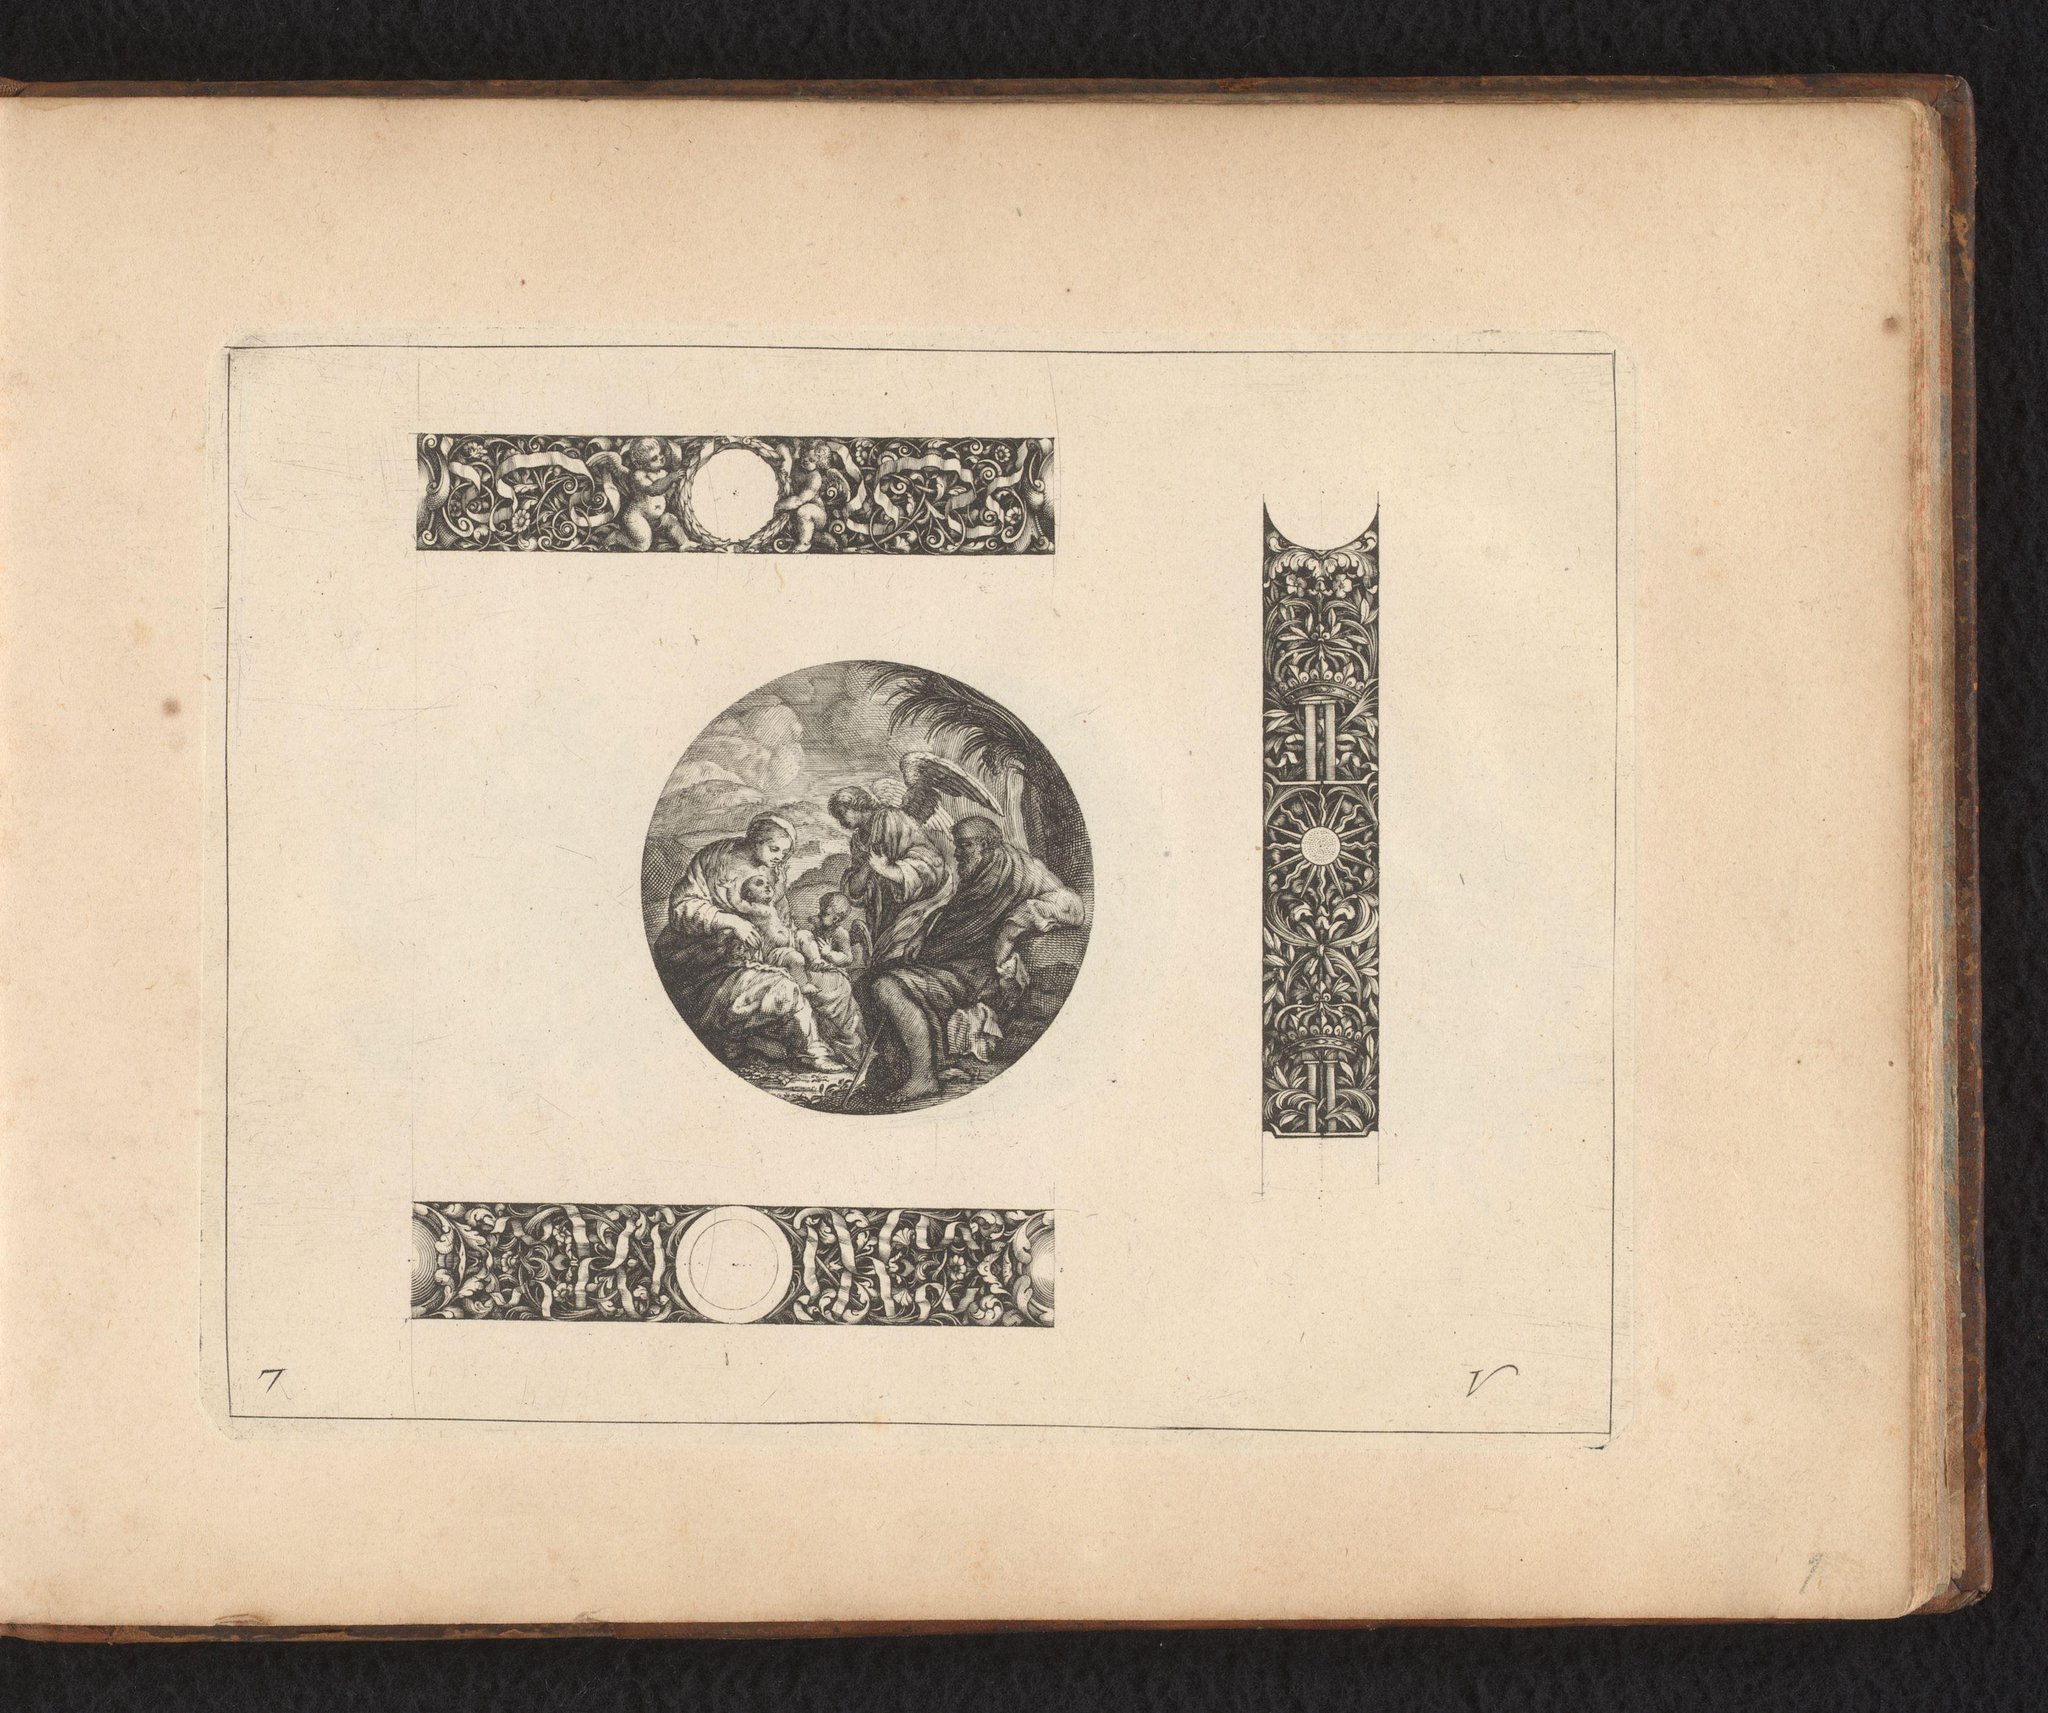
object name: album leaf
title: Edelsmidsontwerpen voor horlogekasten: deksels en zijkanten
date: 1650-1676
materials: paper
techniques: engraving, etching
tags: rest on the flight into egypt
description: Boven, onder en rechts van de horlogekast drie stroken, waarvan de rechter strook met monogram LL gekroond boven een zon (voor Louis XIV). Deze prent maakt deel uit van een album.